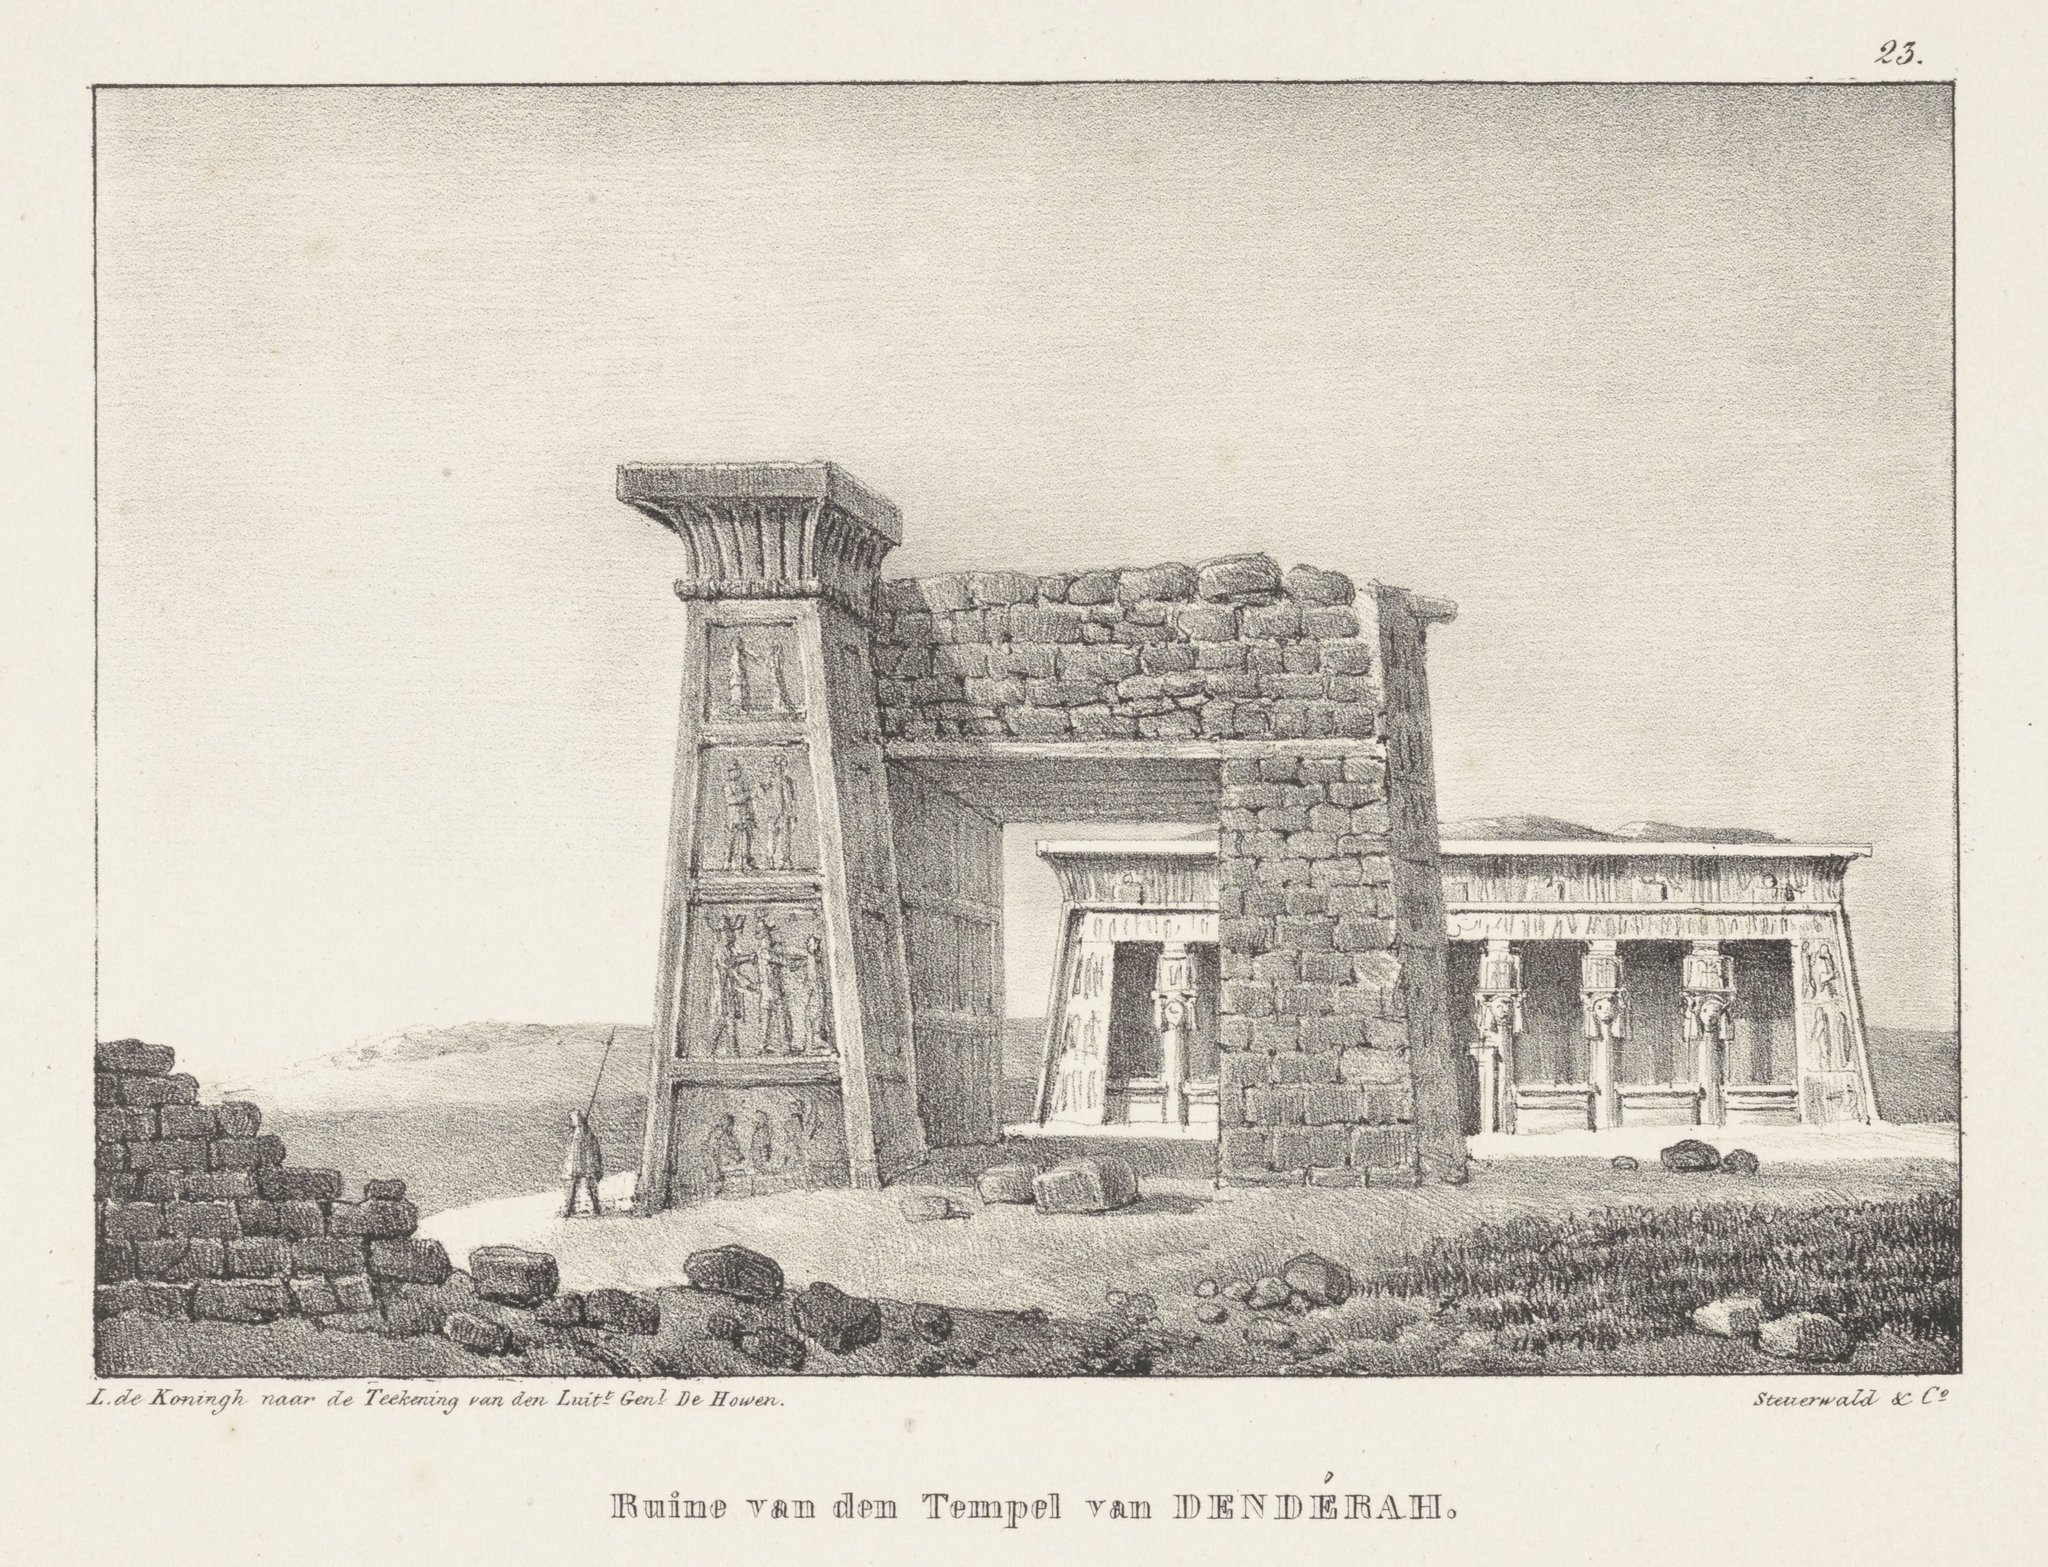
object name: print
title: Ruine van den tempel van Dendérah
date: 1830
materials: paper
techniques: lithograph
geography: egypt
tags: temple, shrine ~ egyptian religion, landscape with ruins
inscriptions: collector's mark: Lugt 2228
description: Deze prent maakte deel uit van een serie. De serie bestaat uit vier omslagen, ieder met een inleidende tekst en zes prenten.